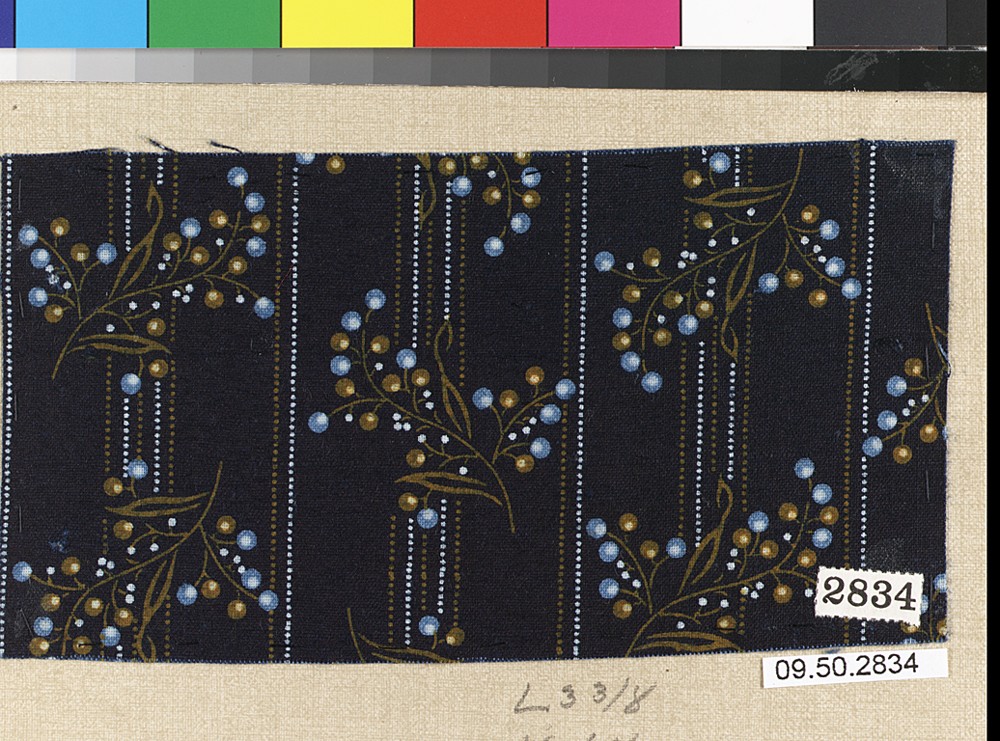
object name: piece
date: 1801-1900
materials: cotton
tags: leaves